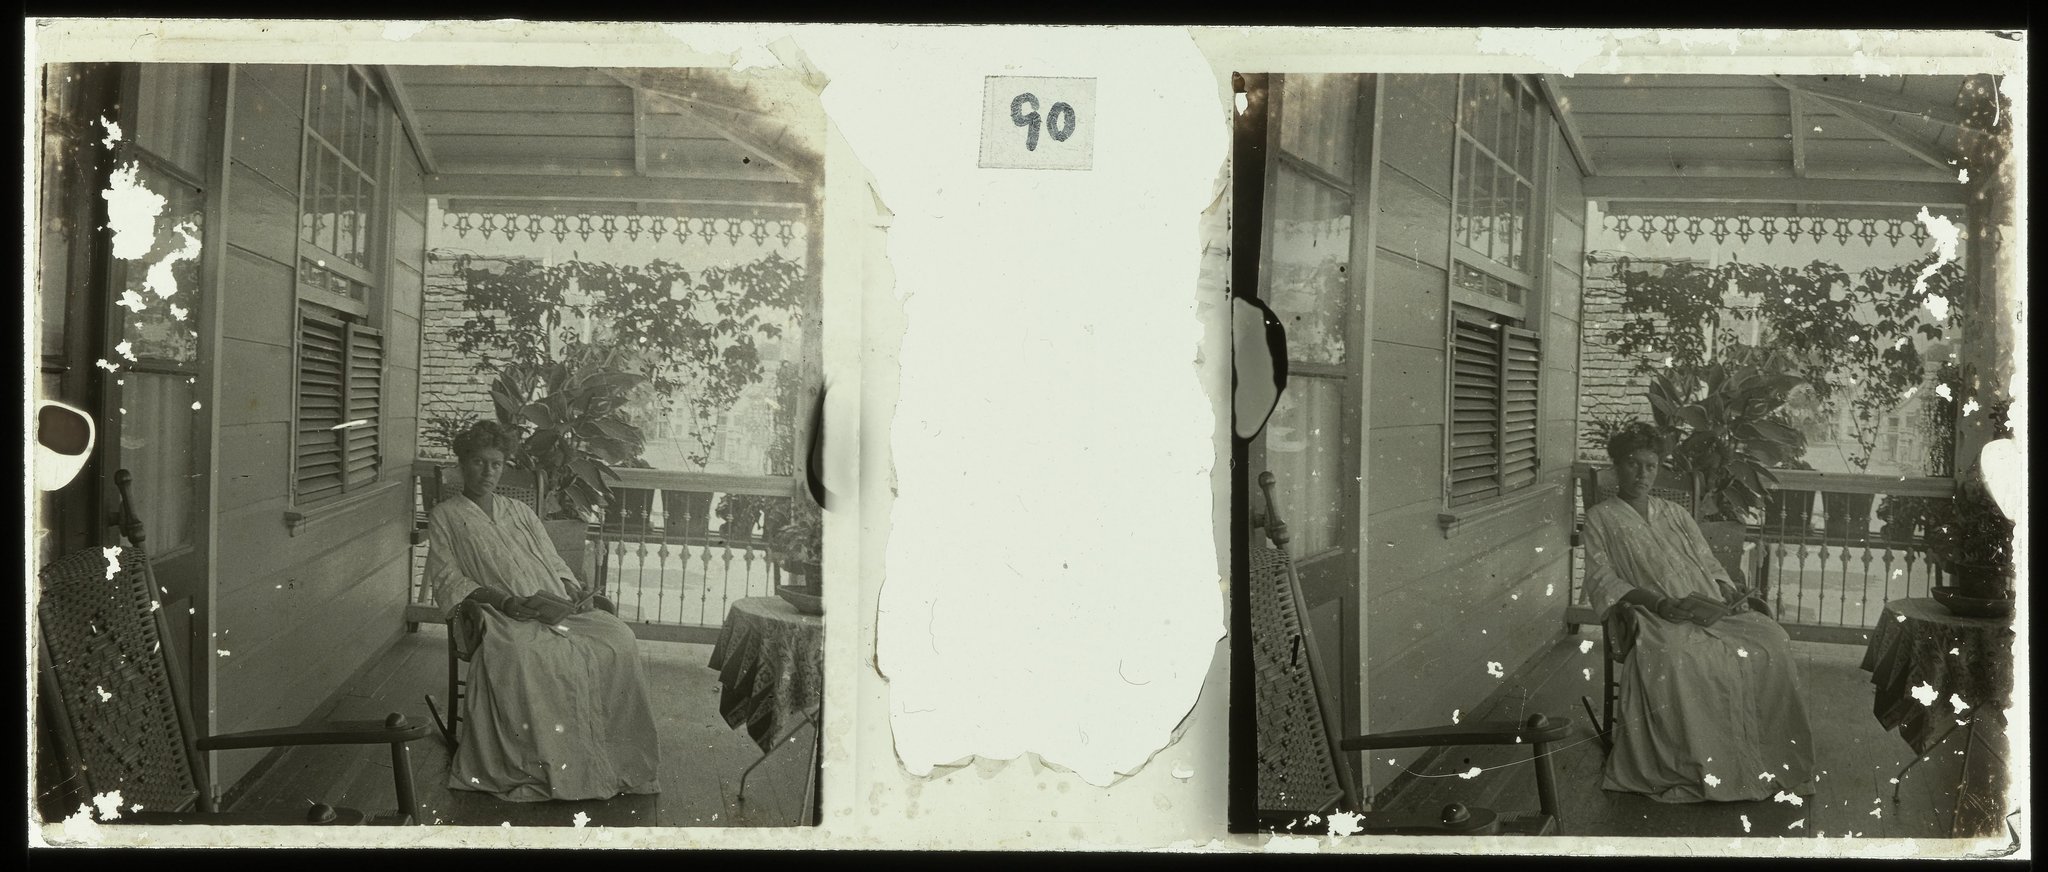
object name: stereograph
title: Heerenstraat 18 in Paramaribo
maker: theodoor brouwers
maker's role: amateurfotograaf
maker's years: 1874-1932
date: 1913-1930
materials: glass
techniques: photography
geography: suriname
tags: theodoor brouwers, suriname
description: In de periode 1911-1932 woonde op plantage Accaribo in Suriname de familie Brouwers van wie de foto's afkomstig zijn. Rond 1910 vond Theodoor Brouwers werk op plantage Accaribo. In 1929 werd hij eigenaar van de plantage. Op Accaribo werden in zijn tijd bananen geproduceerd en wat koffie.